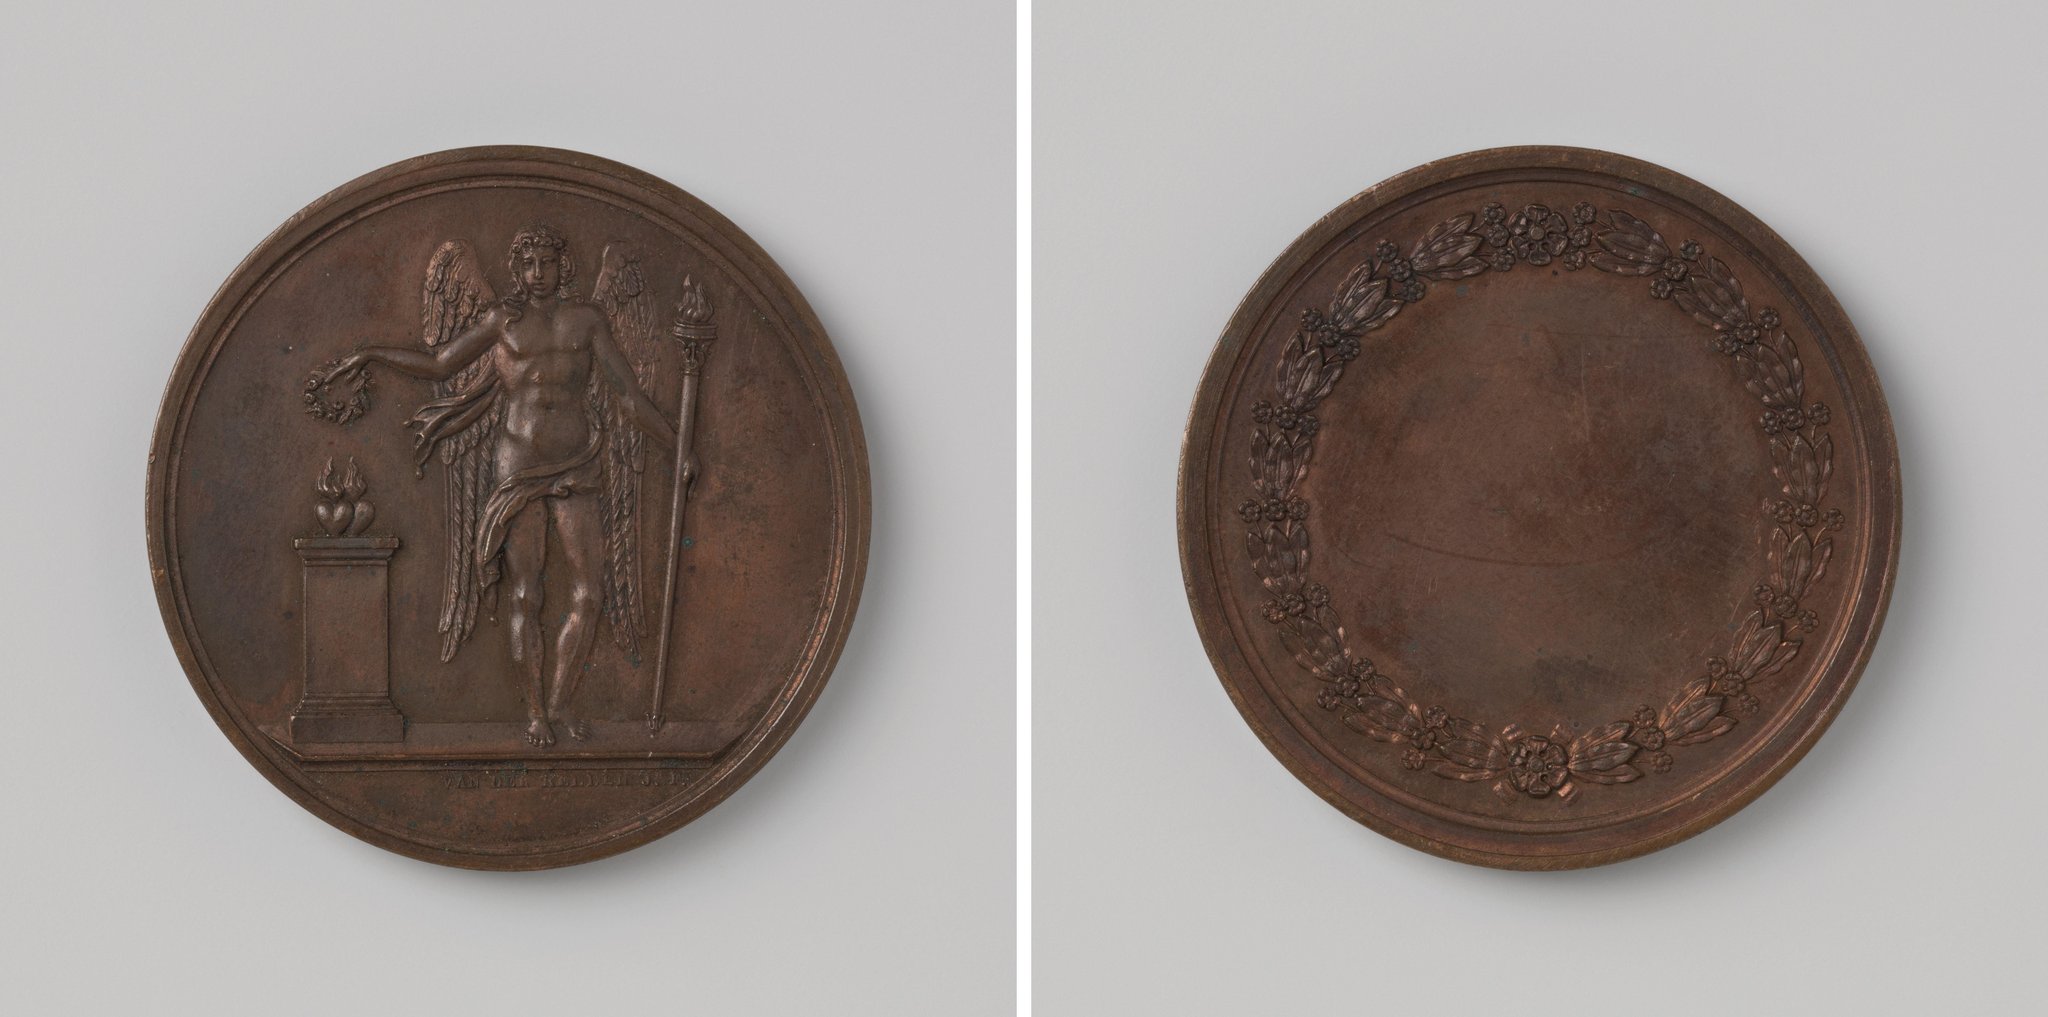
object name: marriage medal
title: Twaalfeneenhalfjarig huwelijk van F.I. van Heeckeren van Brandsenburg en C.A. Voorduin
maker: david van der kellen (1804-1879)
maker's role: die cutter, draughtsman, print maker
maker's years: 1804-1879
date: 1824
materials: bronze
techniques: striking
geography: utrecht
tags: frans jan baron van heeckeren van brandsenburg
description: Bronzen penning. Voorzijde: gevleugelde huwelijksgod Hymen houdt in linkerhand brandende toorts en legt met rechterhand rozekrans op altaar, waarop twee verbonden brandende harten liggen; afsnede: signatuur. Keerzijde: blanco veld binnen myrtekrans. Jubileumpenning ter ere van twaalfeneenhalfjarig huwelijk.